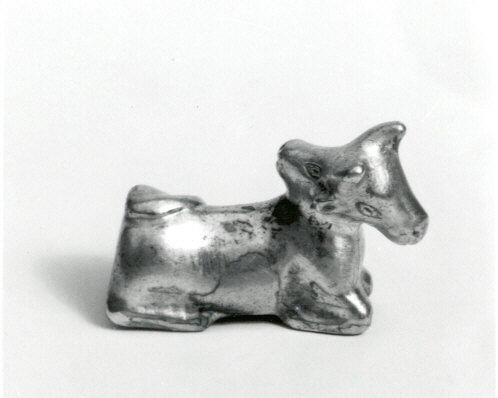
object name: sculpture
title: Two-headed cow figure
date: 3000-1 BCE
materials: silver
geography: anatolia (?)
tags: cows